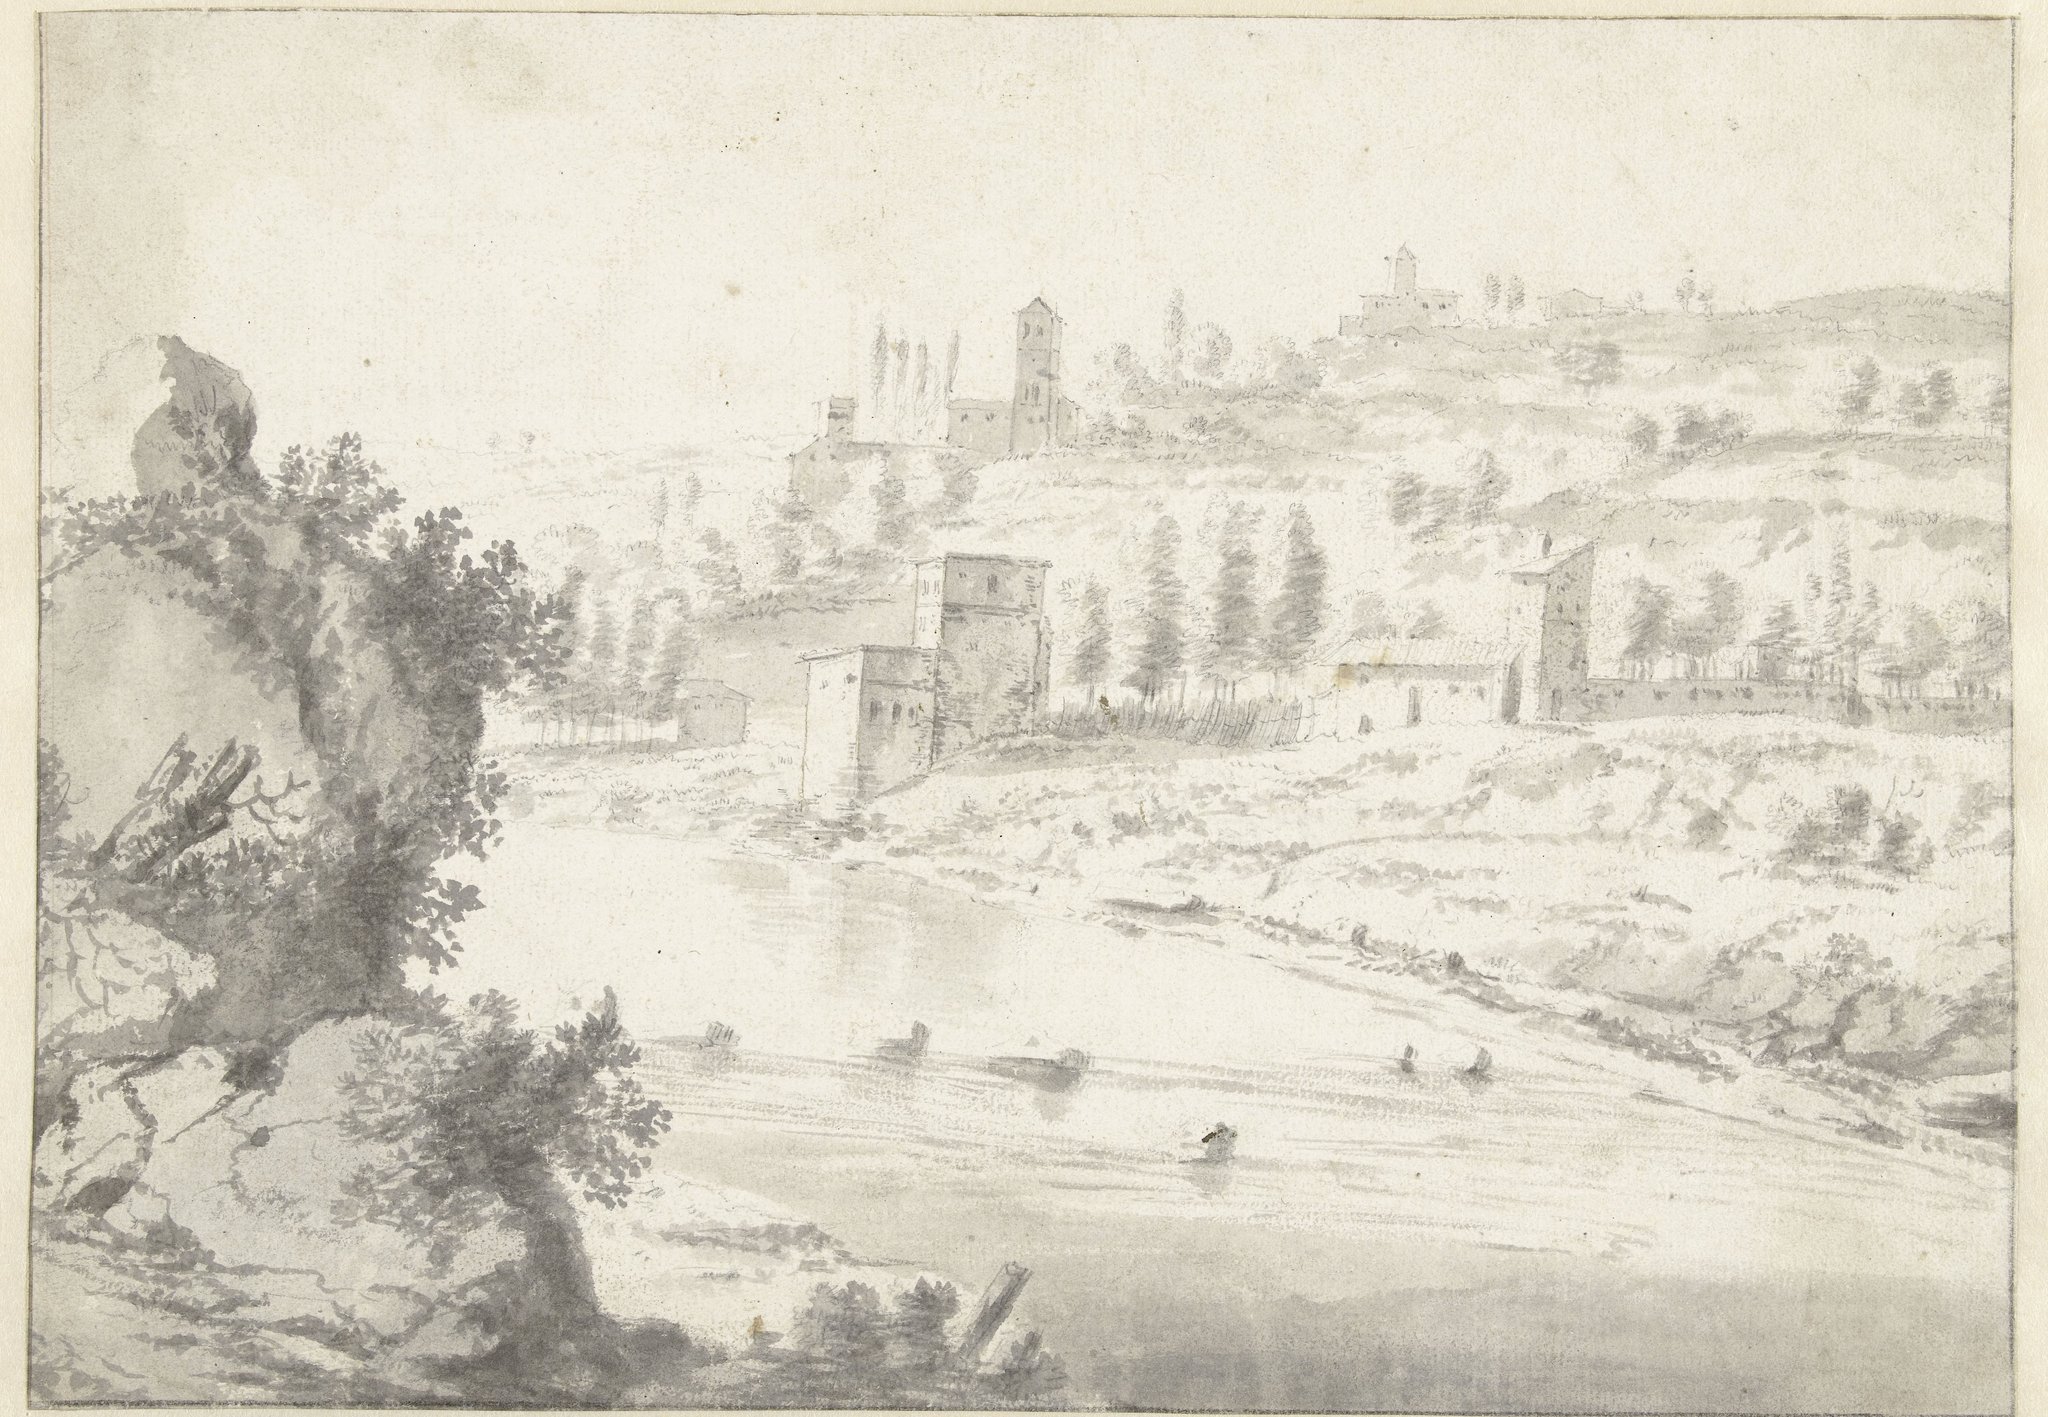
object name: drawing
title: Landscape with the Rhône River Valley, near Vienne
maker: jan worst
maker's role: draughtsman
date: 1655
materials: chalk, ink, paper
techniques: brush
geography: vienne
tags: brook, italy